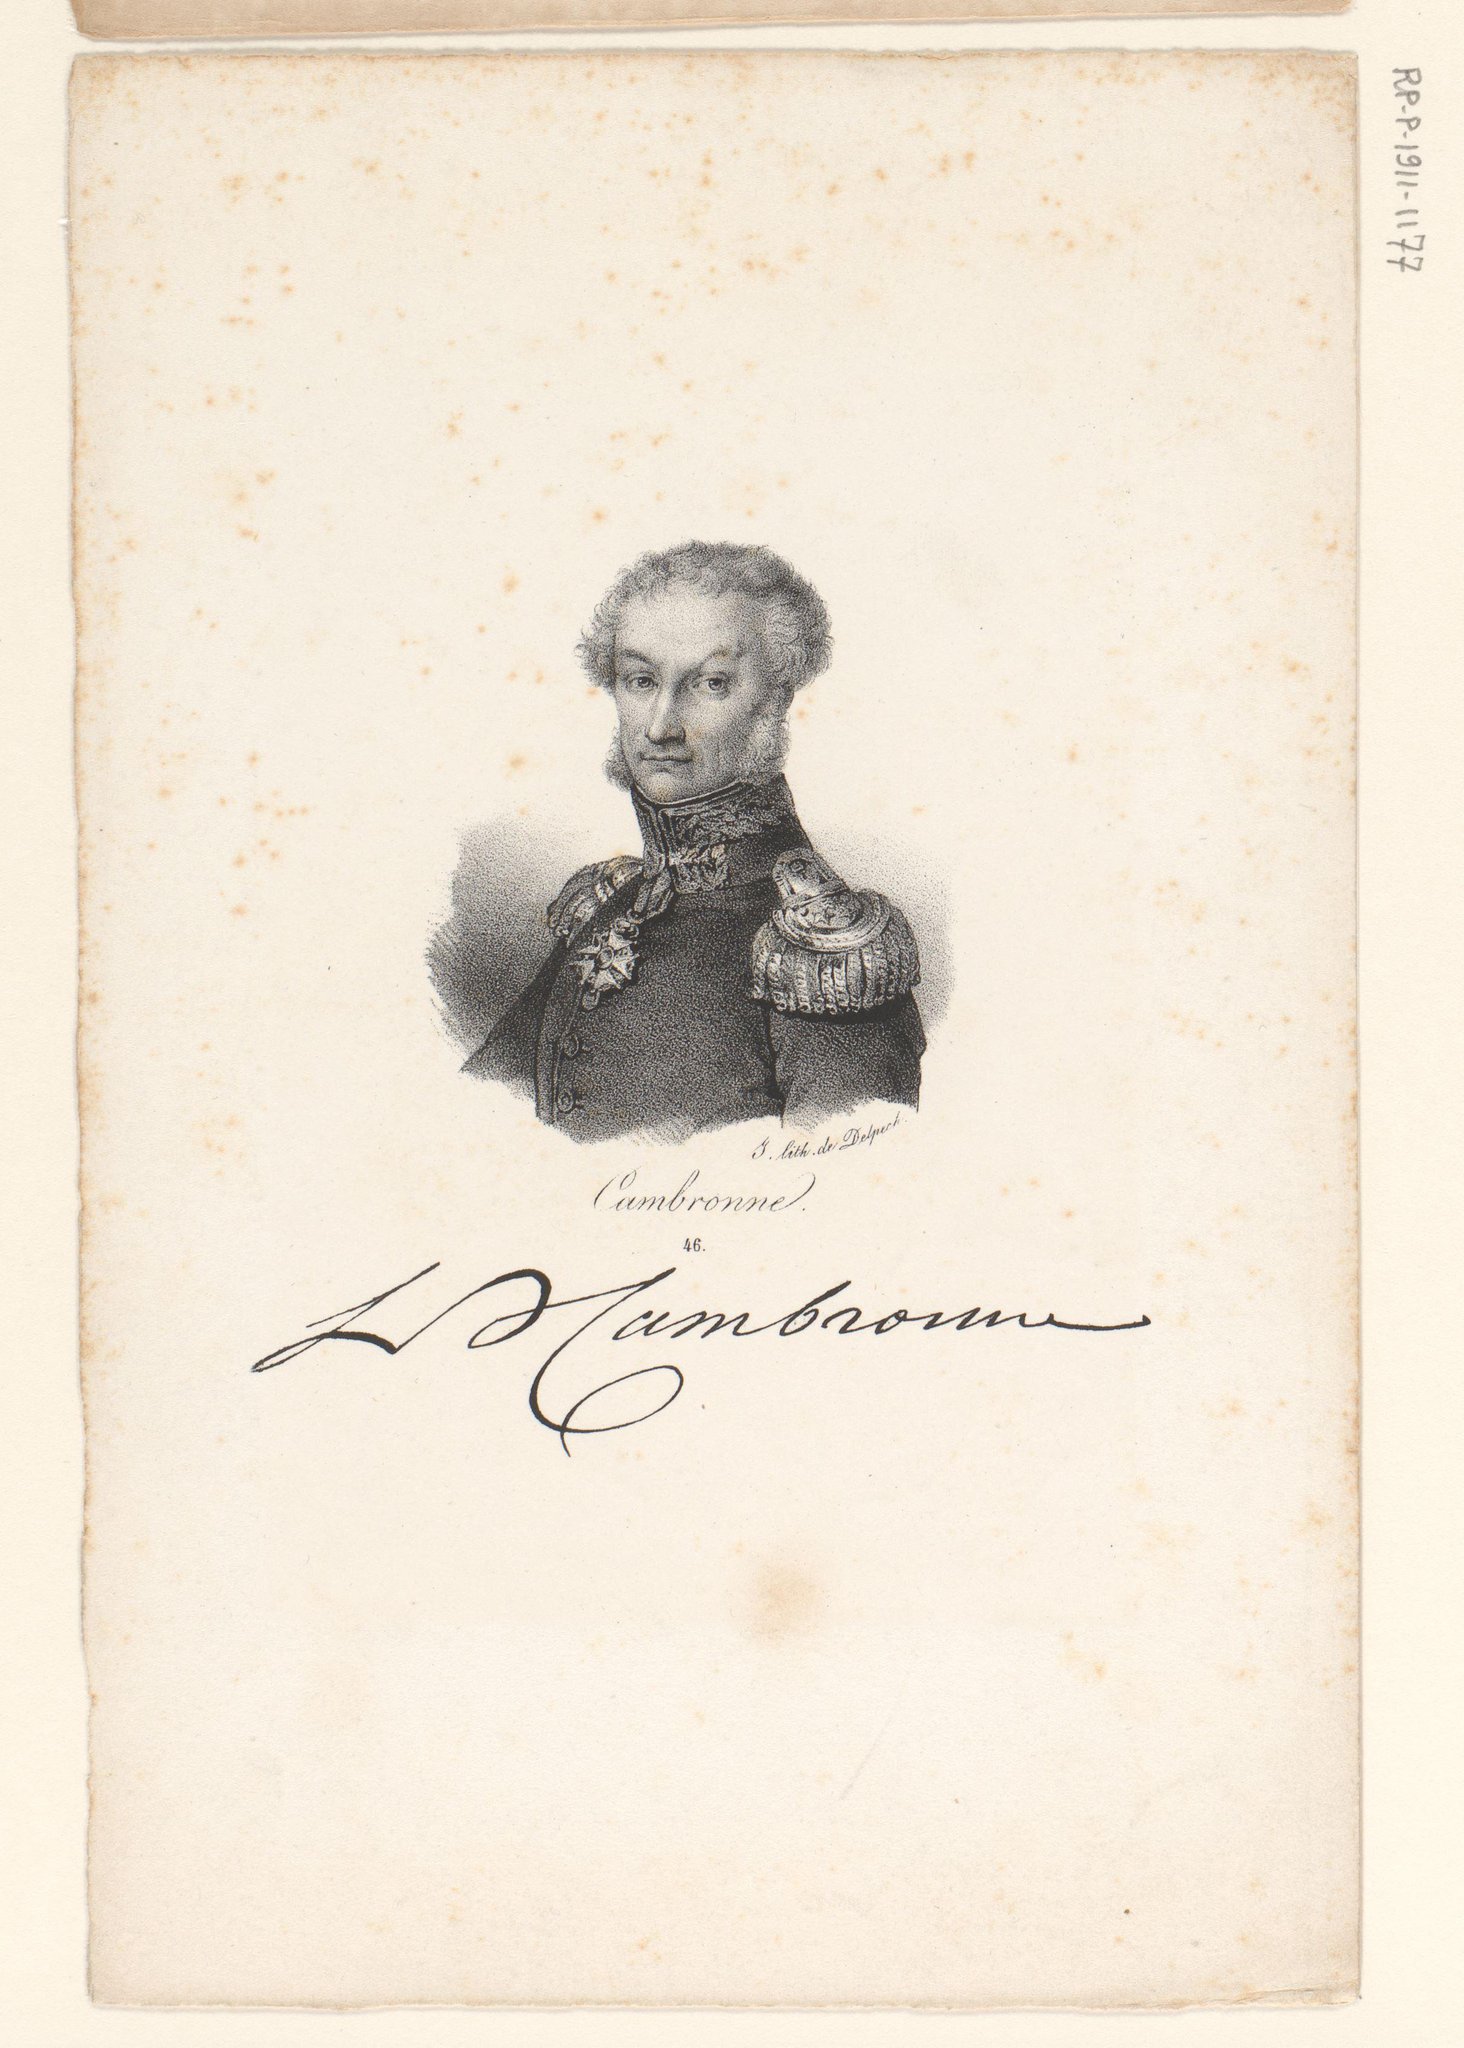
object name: print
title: Cambronne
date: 1818-1842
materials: paper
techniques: lithograph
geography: paris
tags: historical persons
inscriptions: collector's mark: Lugt 2228a